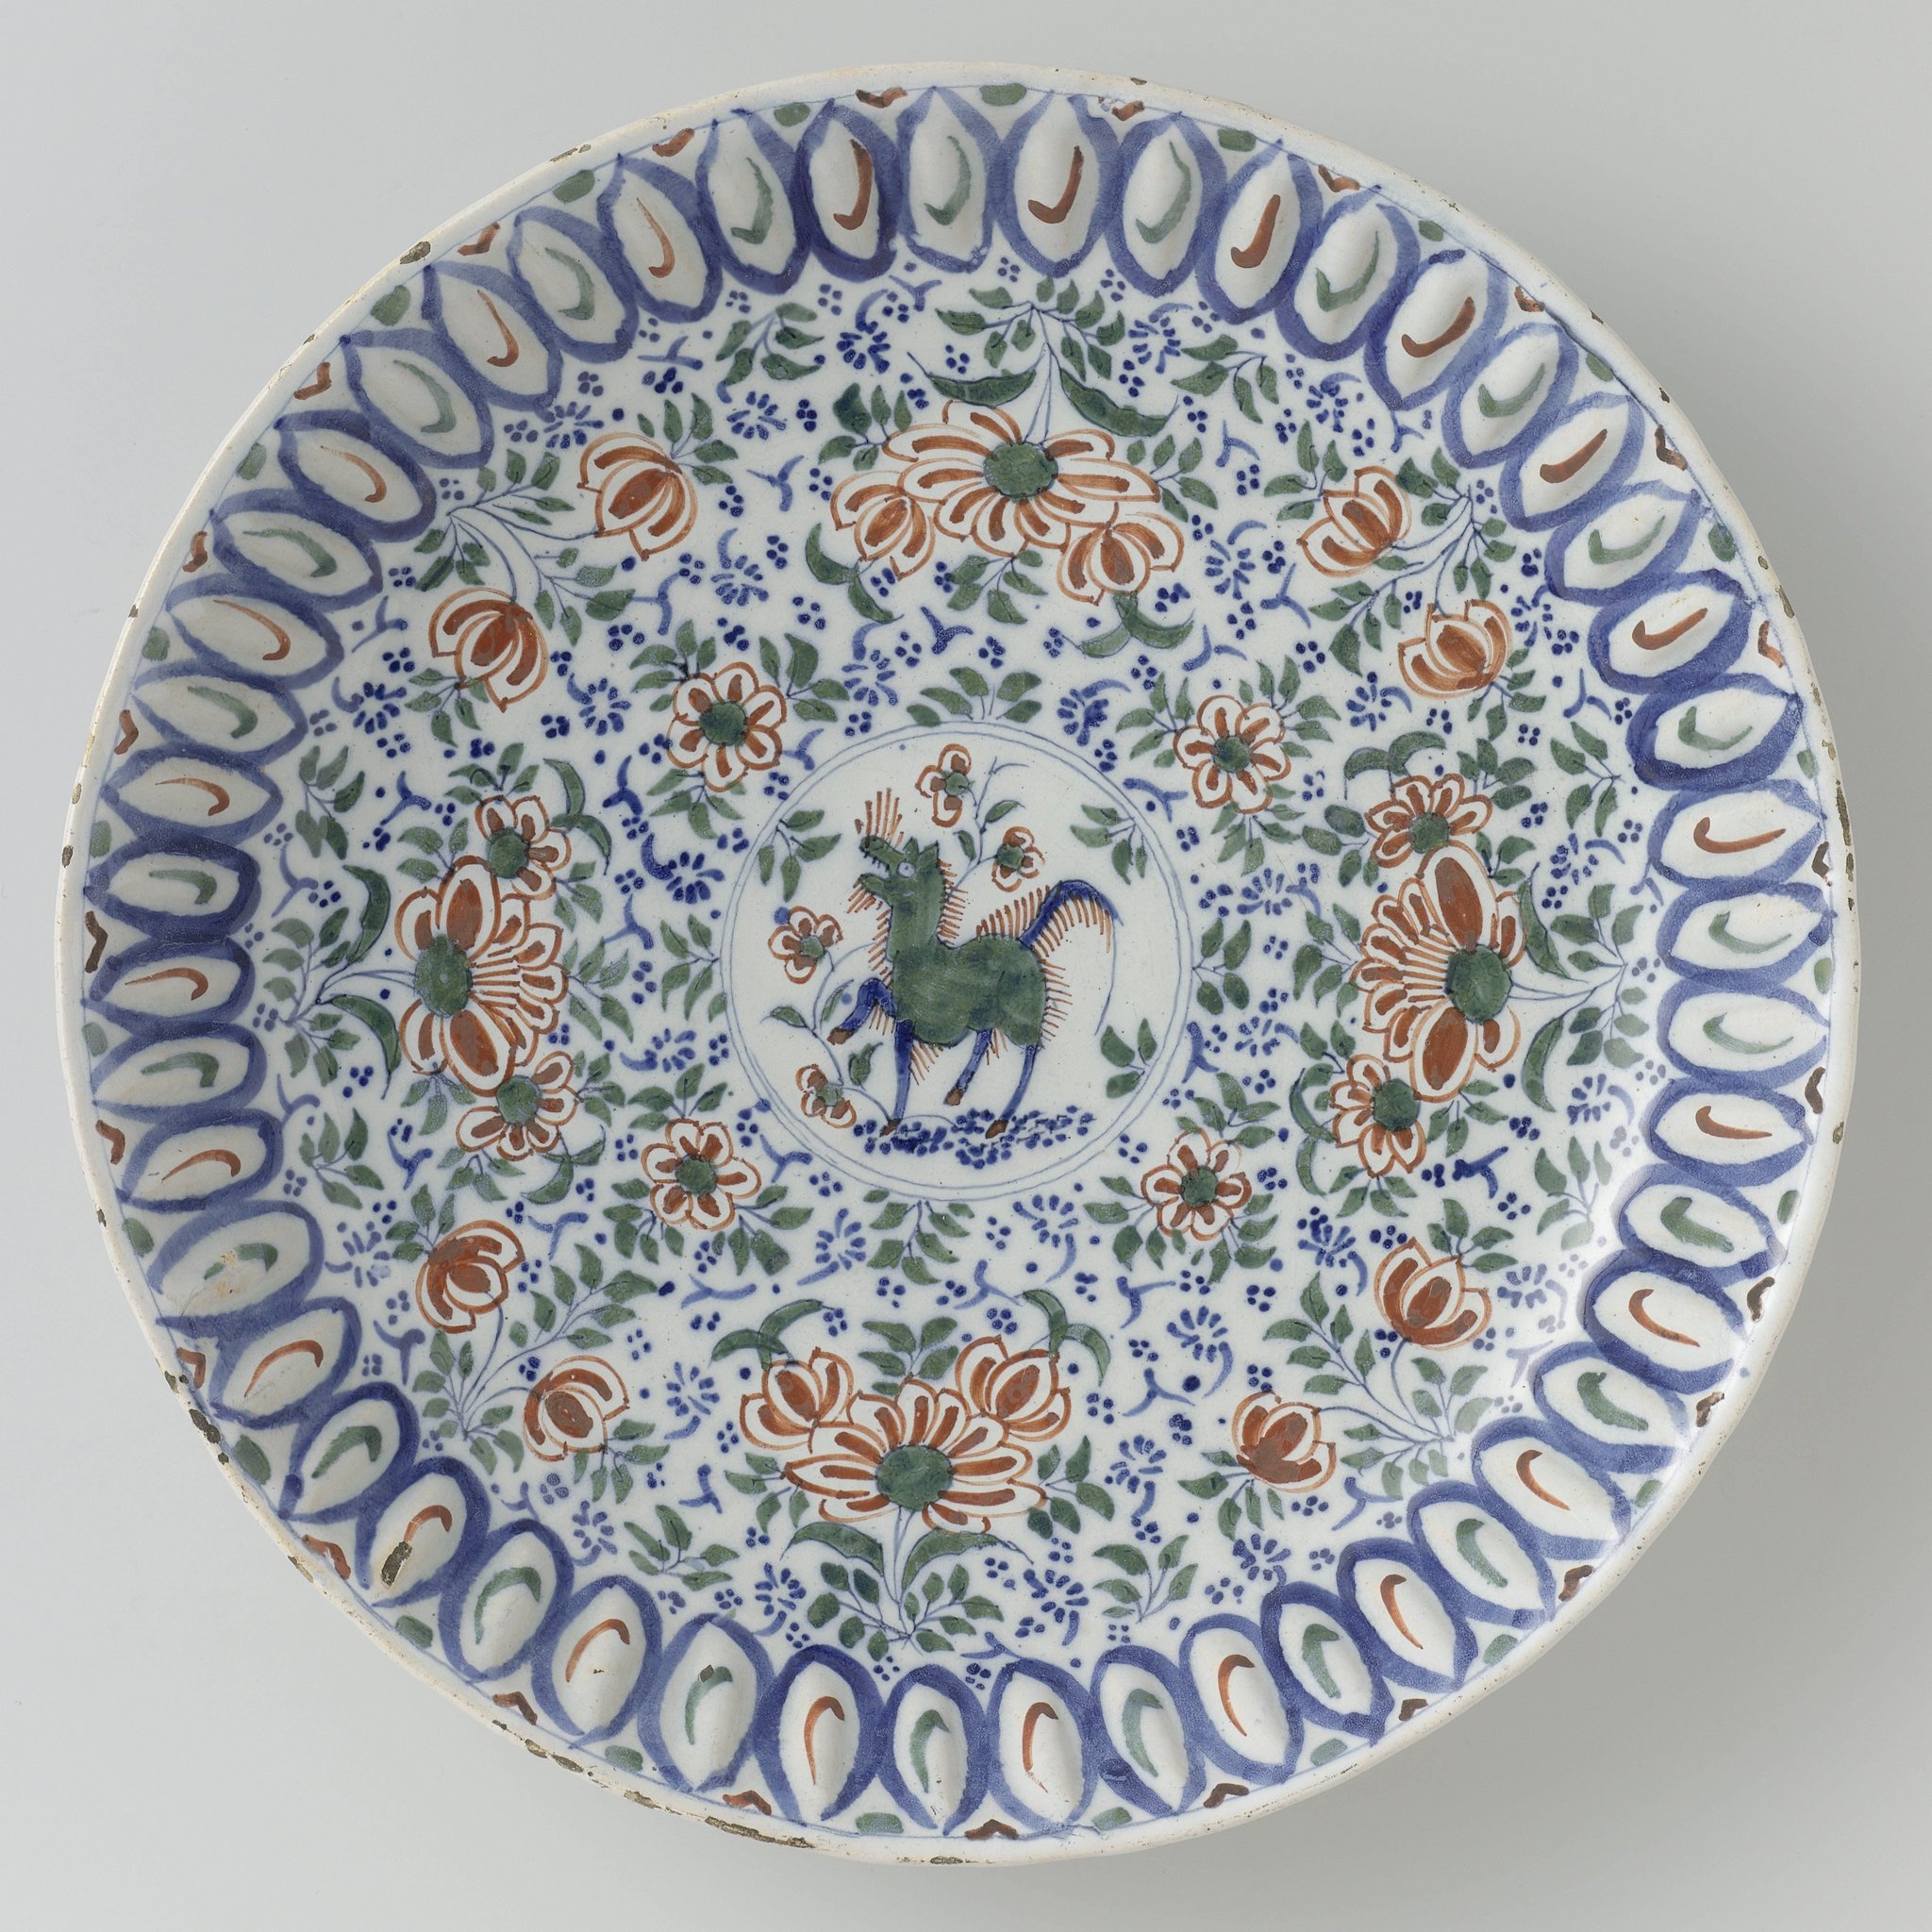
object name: platter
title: Schotel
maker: Anonymous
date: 1710-1740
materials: faience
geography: delft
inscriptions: seal: ‘1136’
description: Schotel van faience. Veelkleurig beschilderd met bloemen en een beest in het midden.